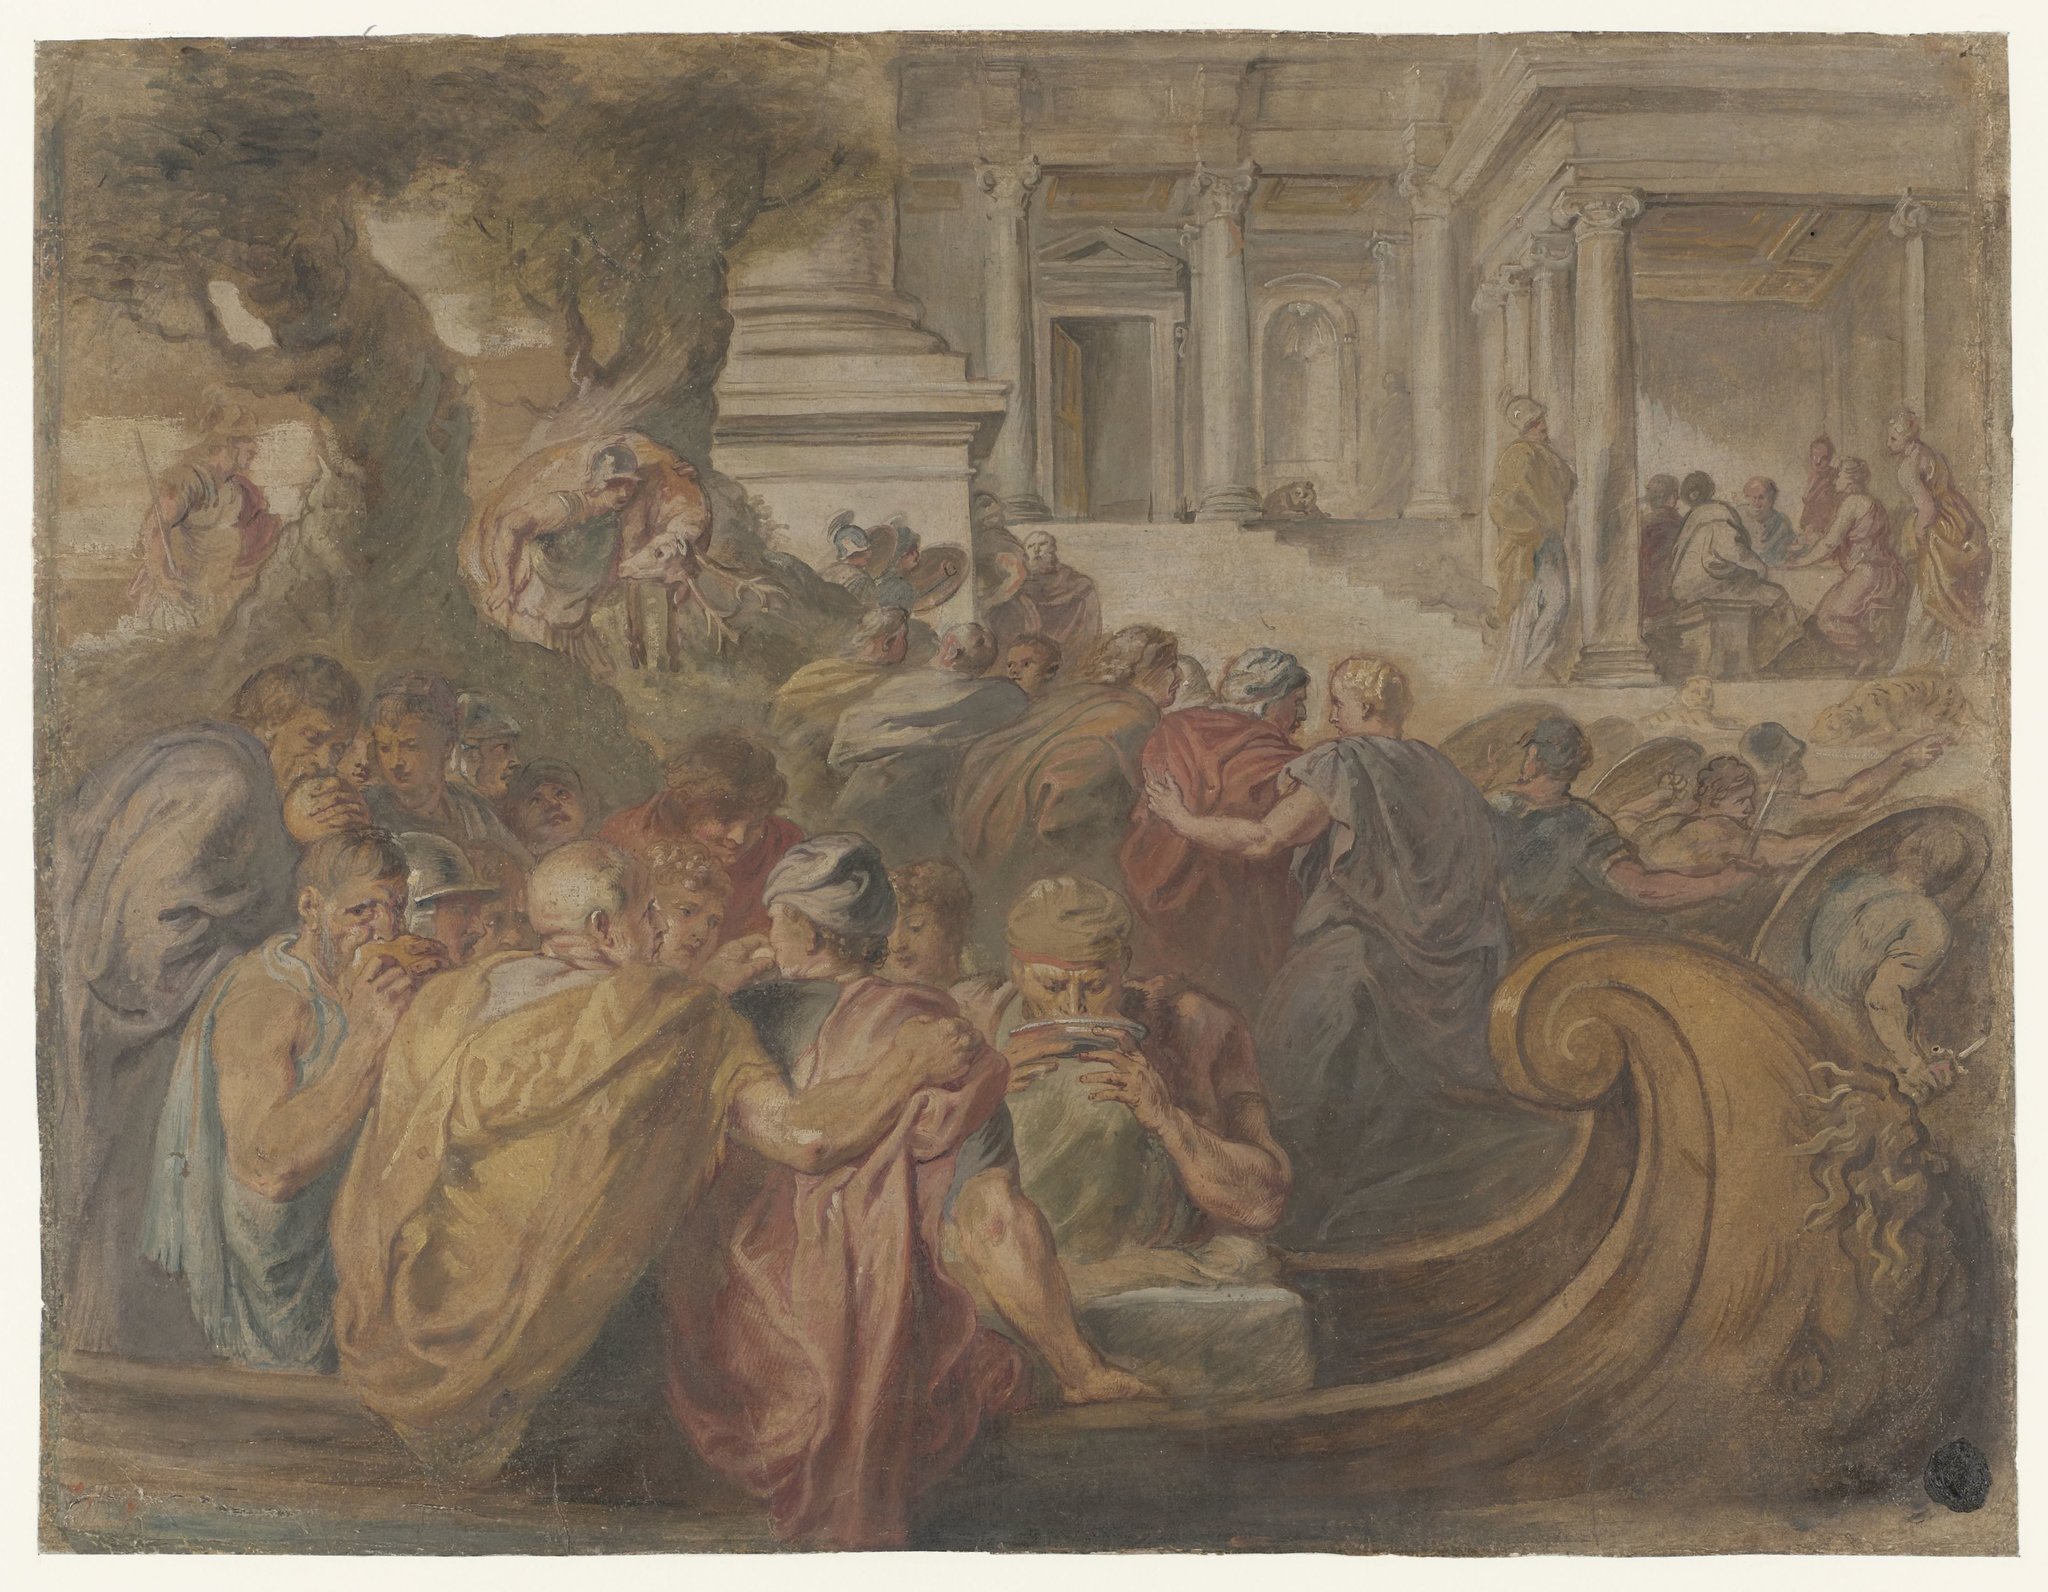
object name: drawing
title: Aankomst van Odysseus en metgezellen bij Circe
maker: peter paul rubens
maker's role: draughtsman, painter, print maker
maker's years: 1577-1640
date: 1587-1640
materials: oil, paper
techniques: brush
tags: circe invites ulysses' men into her palace